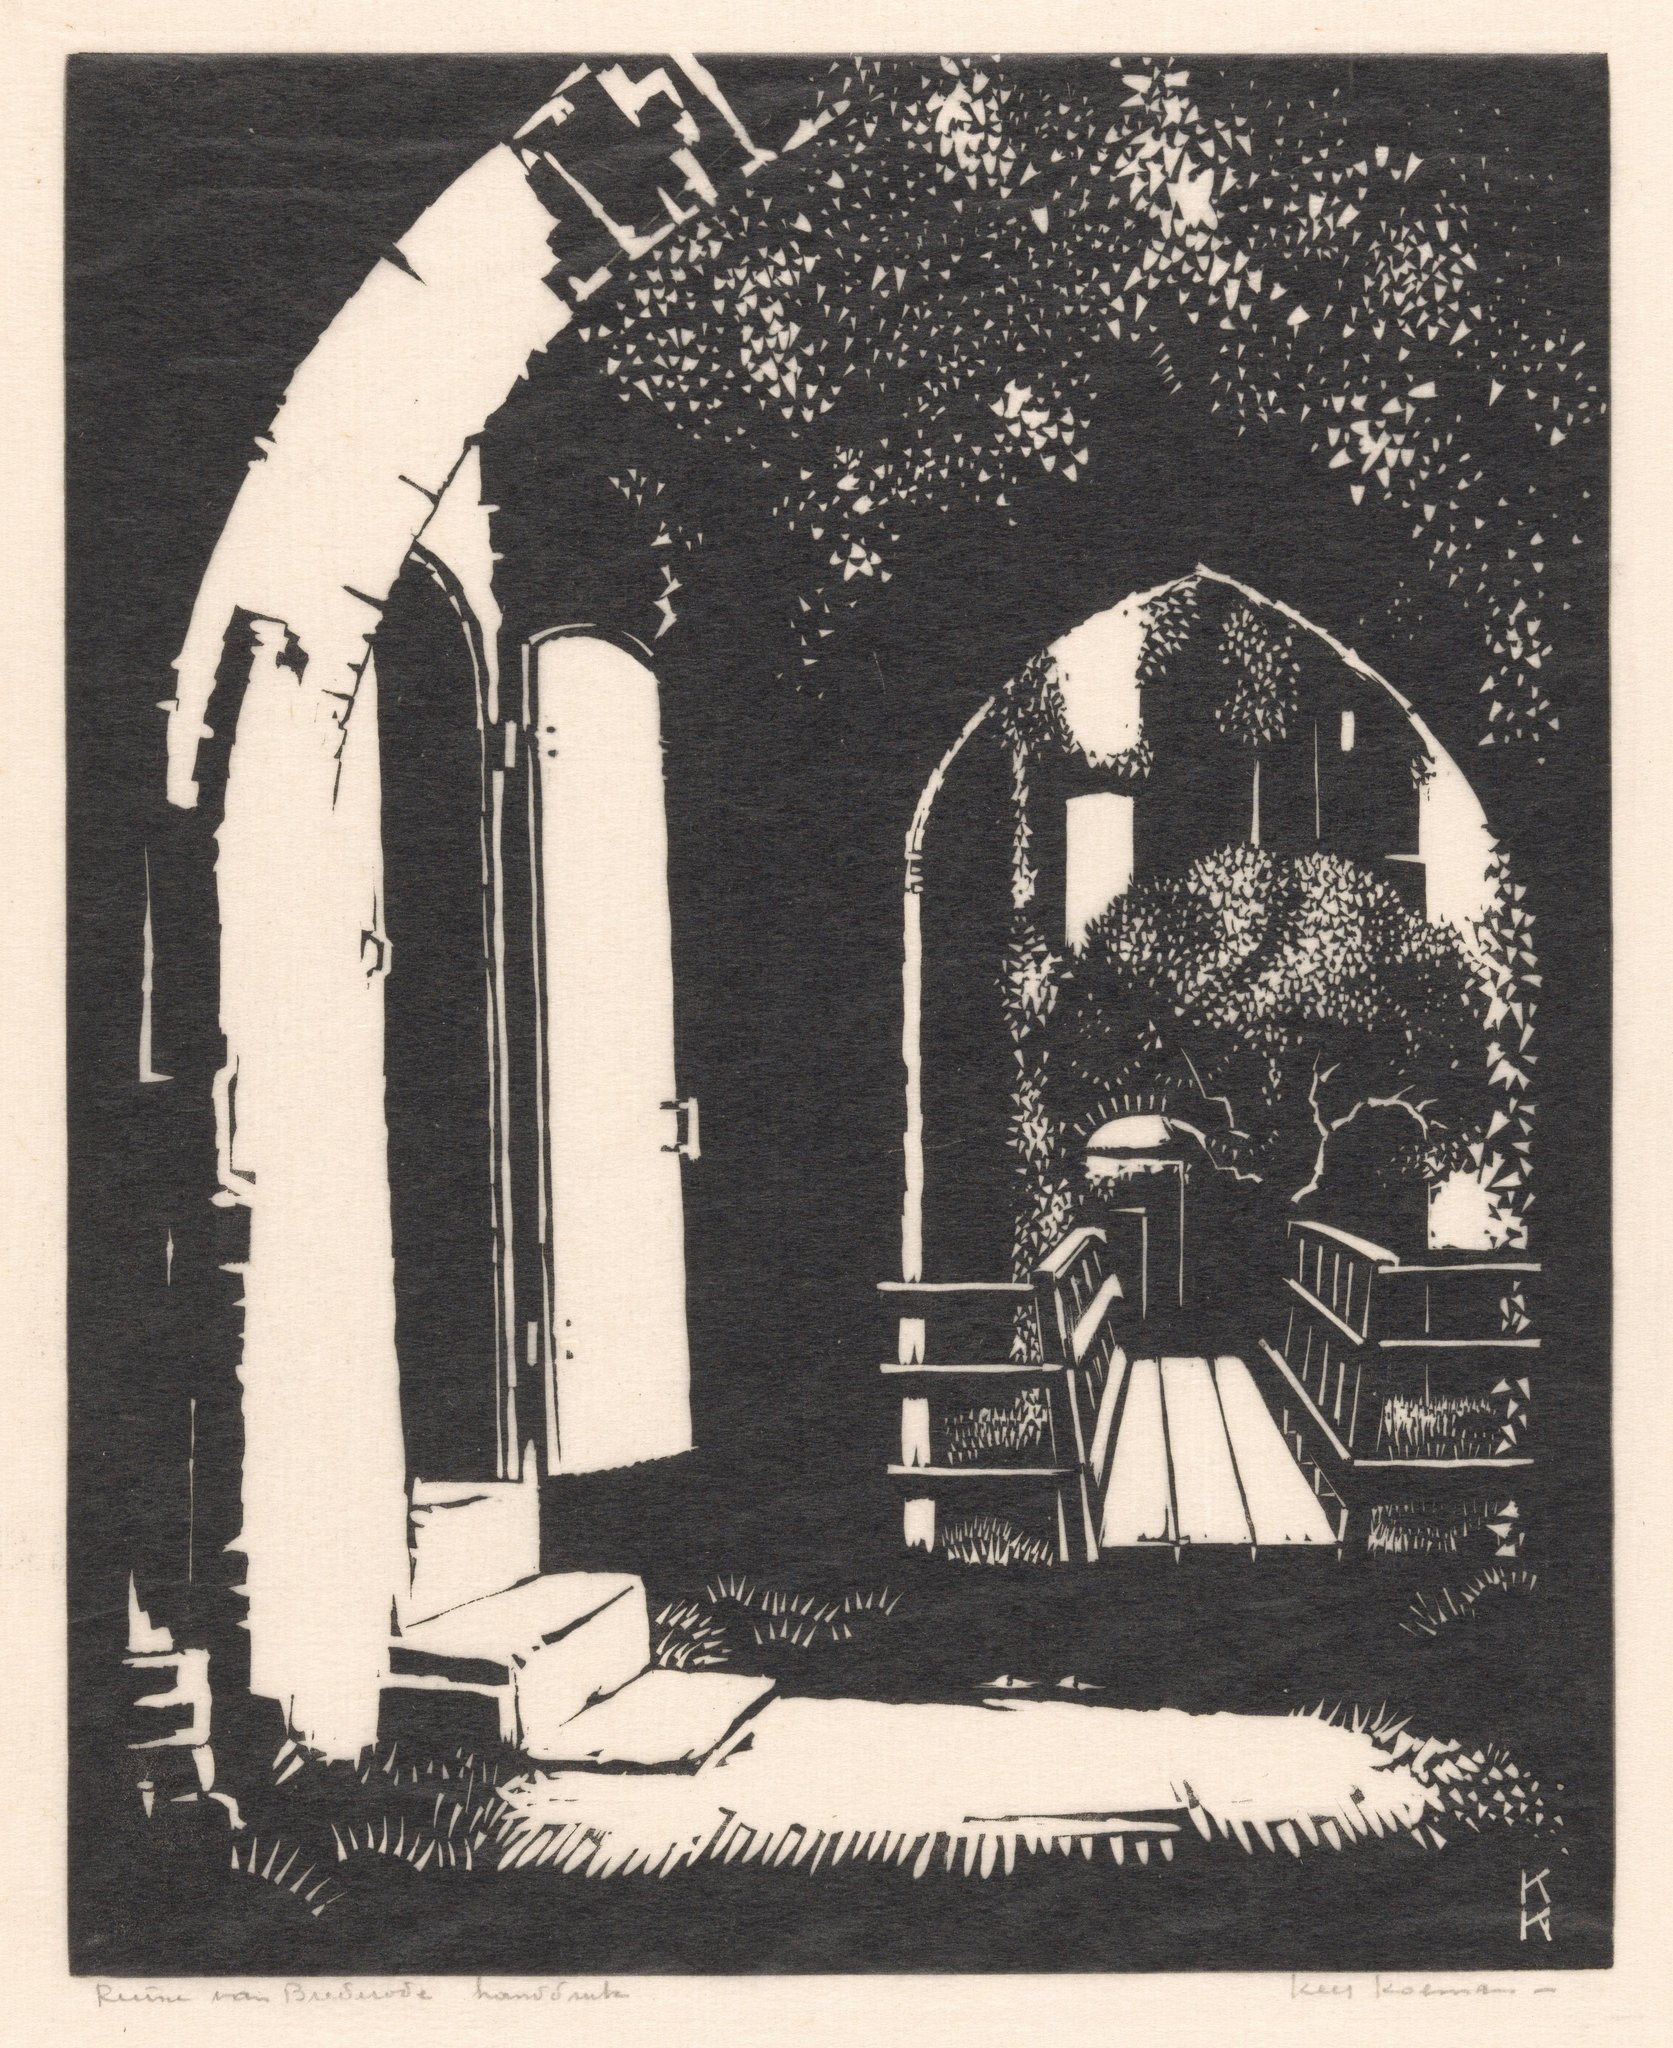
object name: print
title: Ruïne van Brederode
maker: kees koeman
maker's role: print maker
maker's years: 1895-1954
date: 1910-1932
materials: paper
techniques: woodcut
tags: ruin of a dwelling, house, castle, etc., santpoort-zuid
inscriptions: collector's mark: Lugt 2228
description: Rechts een brug en een boom; links staat een deur open.